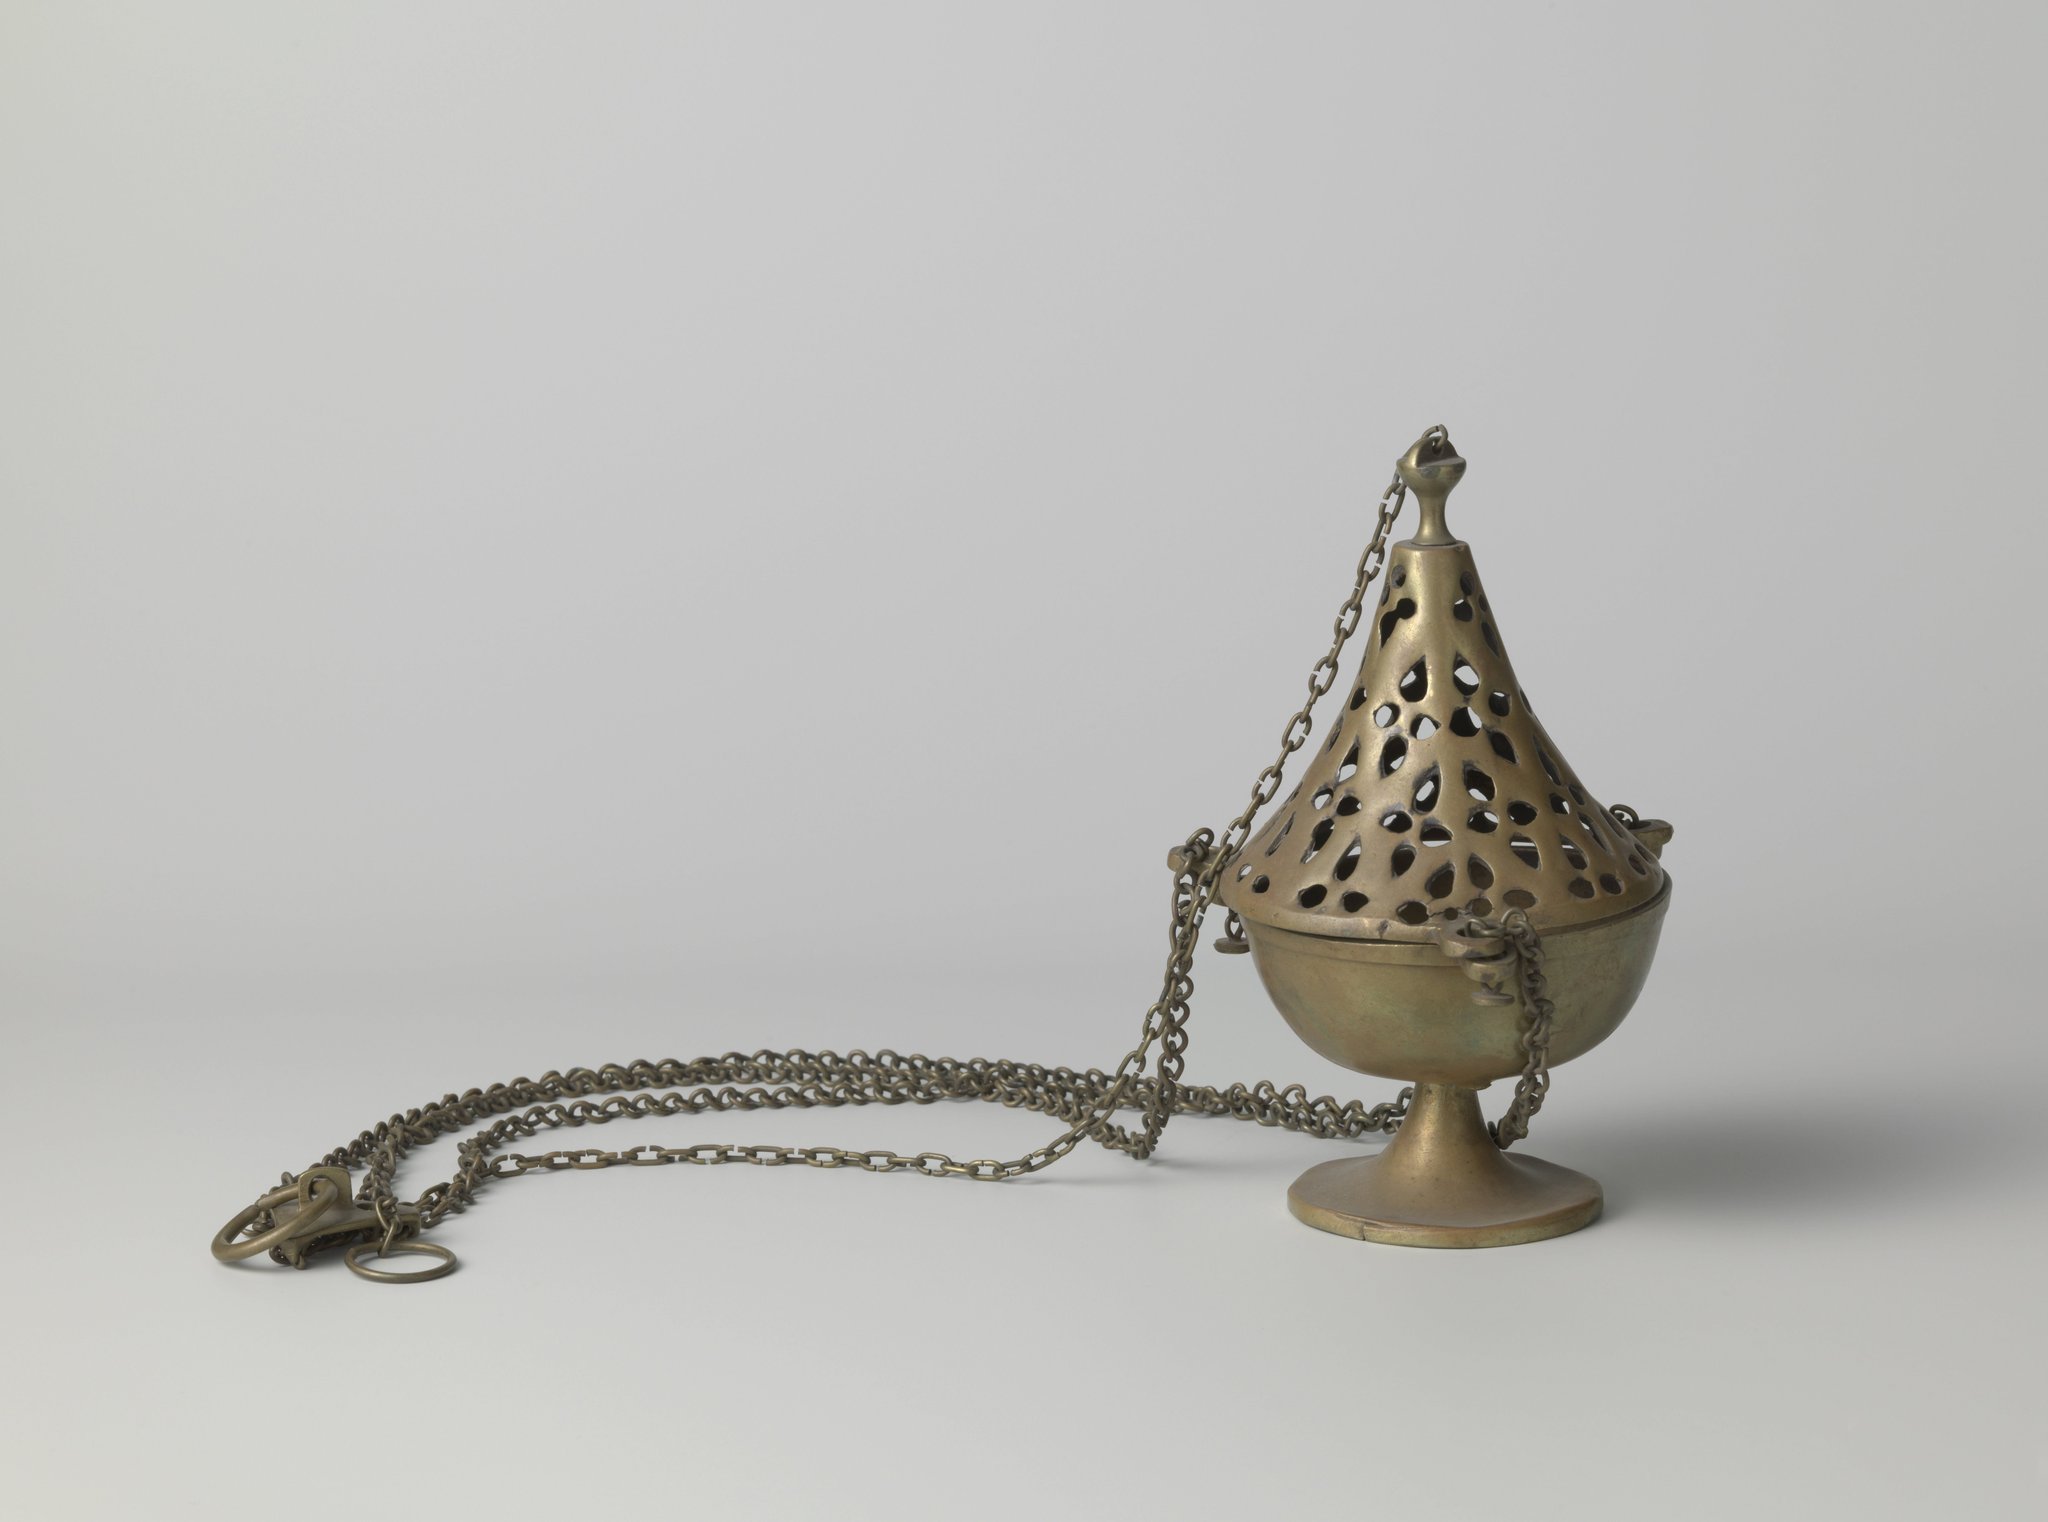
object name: censer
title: Wierookvat met rond en spits toelopend deksel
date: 1400-1500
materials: brass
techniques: casting, metalworking, embroidery, riveted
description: De onderdelen zijn gegoten en bijgeciseleerd, met uitzondering van de kettingen. De bolvormige kuip is op een vernieuwde ronde voet geklonken. Het opengewerkte ingezwenkte kegelvormige deksel is voorzien van een knop. Deksel en kuip hebben drie paar ogen. De driehoekige ringdrager heeft een gat voor de dekselketting. De kettingen zijn vernieuwd.